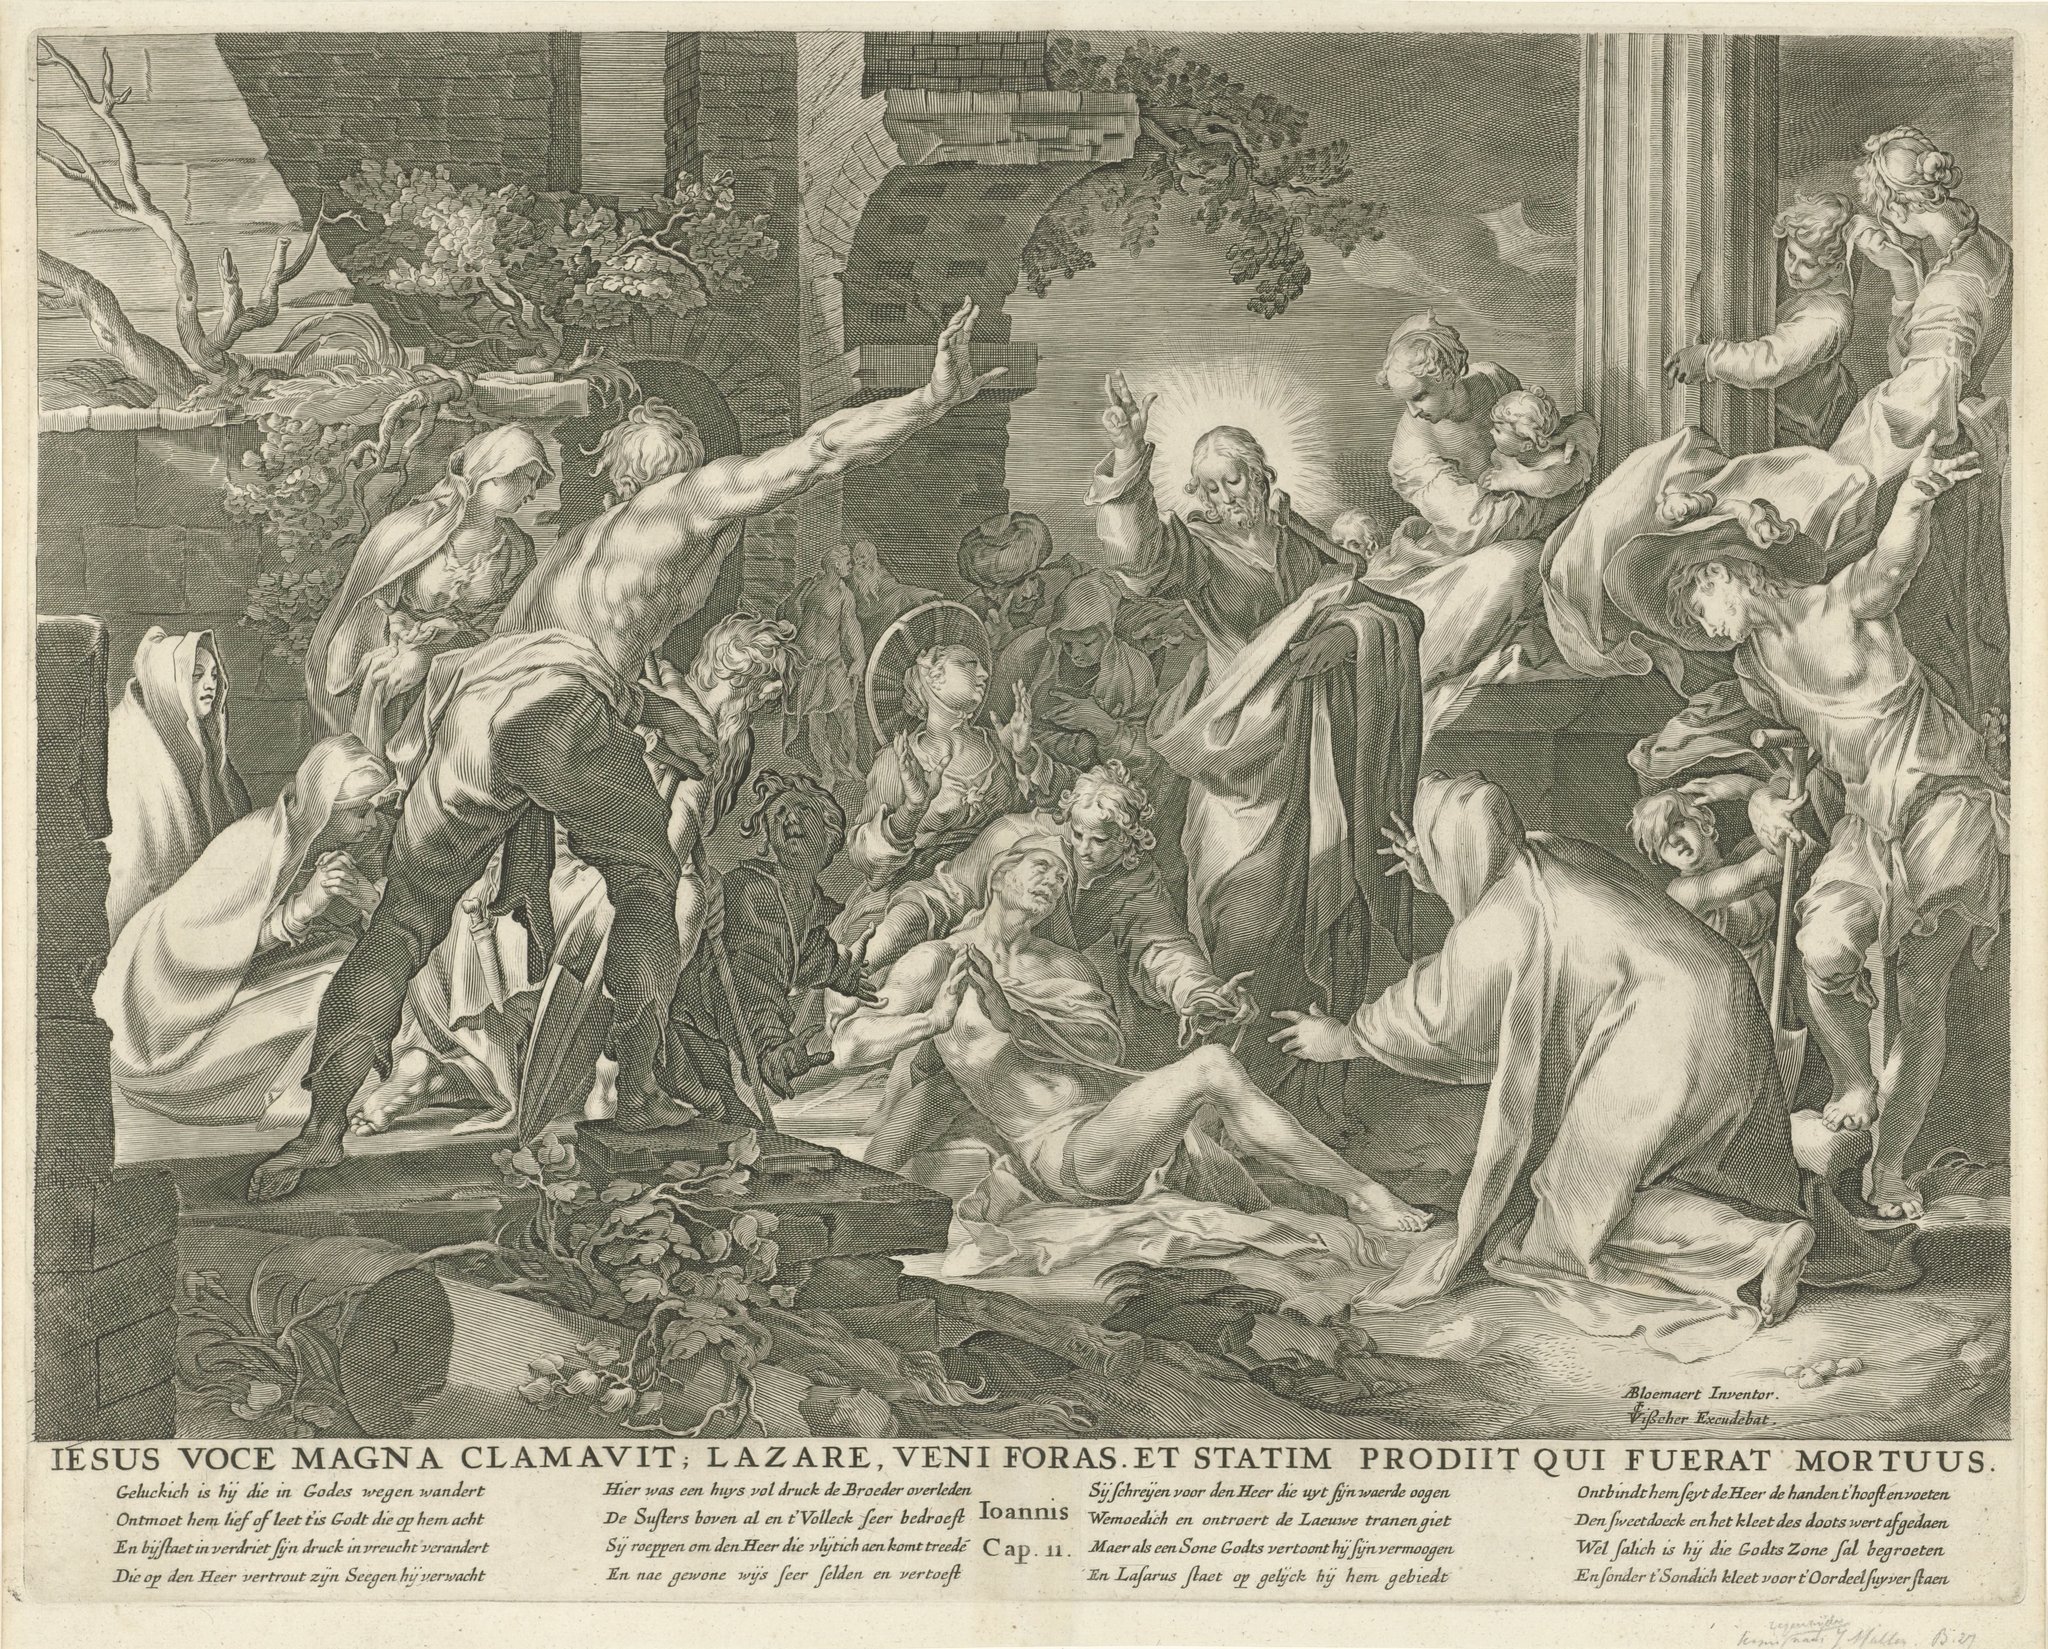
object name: print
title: Opwekking van Lazarus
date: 1601-1652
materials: paper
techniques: engraving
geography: amsterdam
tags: the raising of lazarus ('lazarus, come out')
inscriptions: collector's mark: Lugt 2228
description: Christus wekt Lazarus op uit de dood. De omstanders reageren verbaasd en verwonderd. Onderaan in de marge een tekstregel in het Latijn en vier vierregelige verzen in het Nederlands.